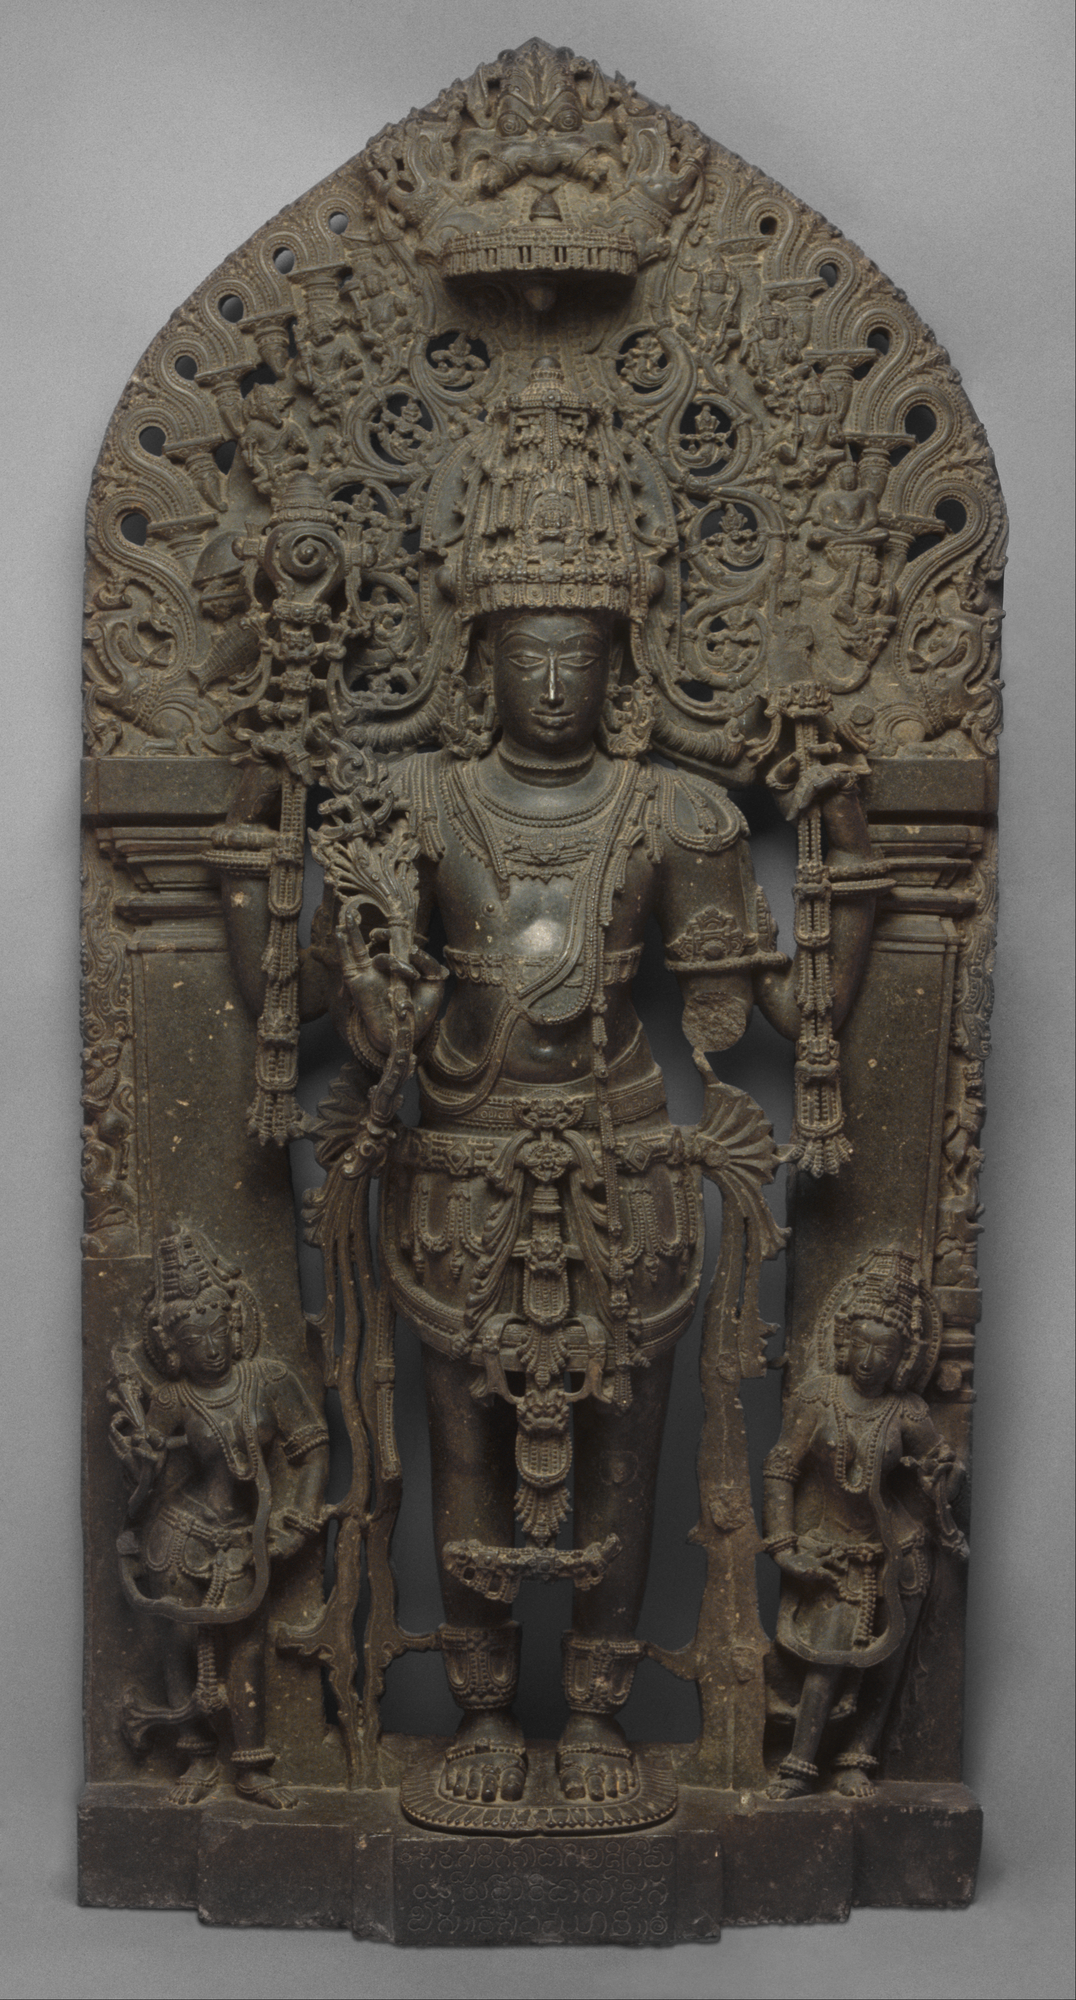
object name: figure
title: Standing Vishnu as Keshava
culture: indian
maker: dasoja of balligrama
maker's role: artist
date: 1101-1125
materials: stone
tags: vishnu